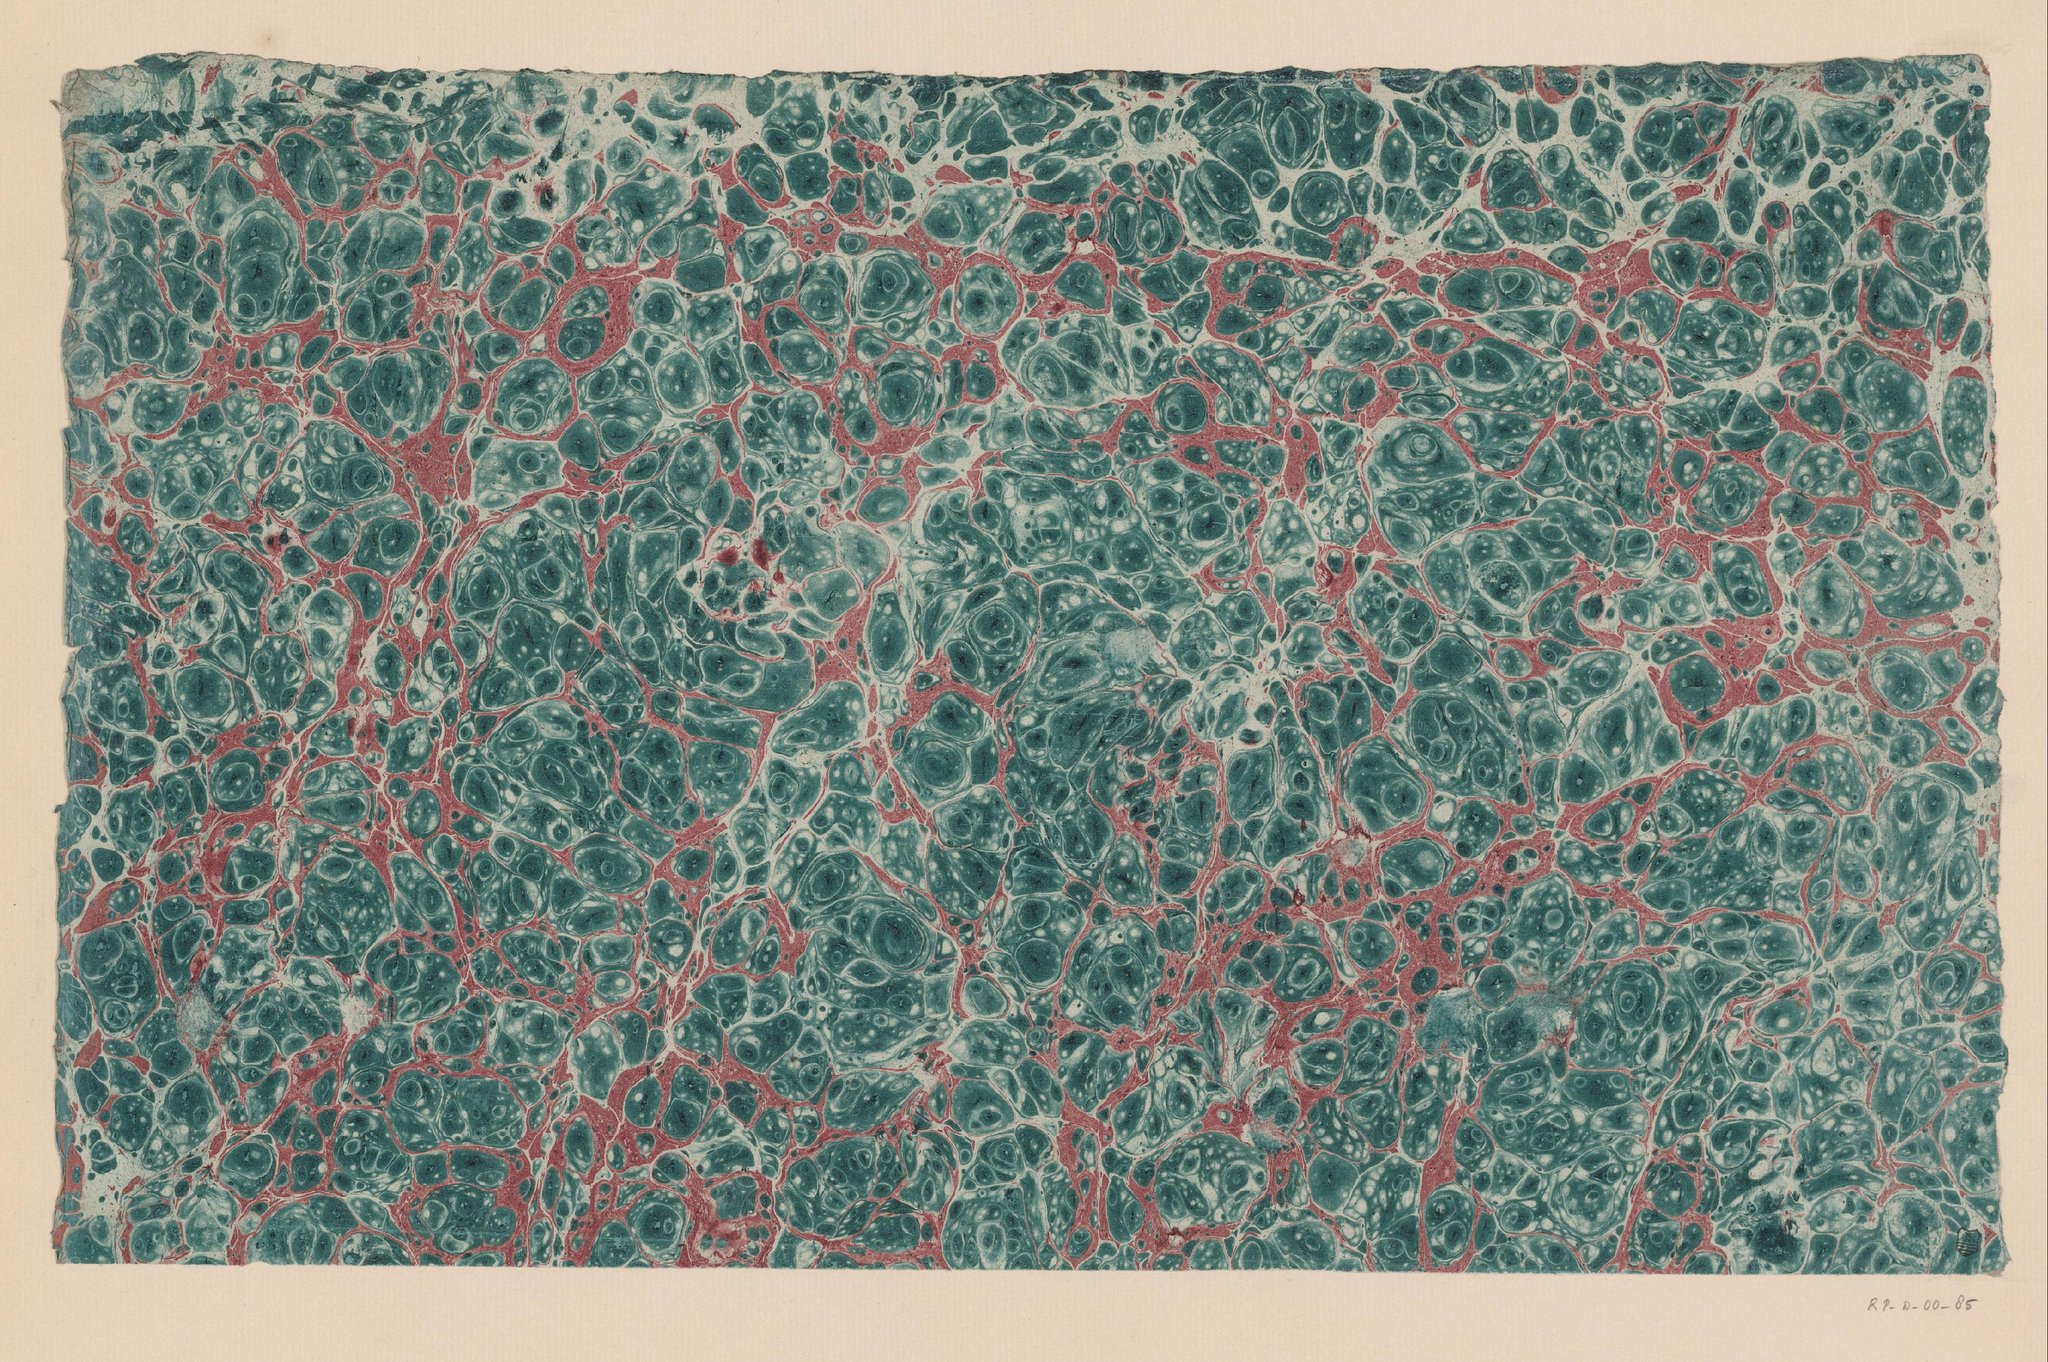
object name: marbled paper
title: Ringkiezelmarmer in groen en roze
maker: Anonymous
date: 1700-1850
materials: paint, paper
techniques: marbled paper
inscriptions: collector's mark: Lugt 2760